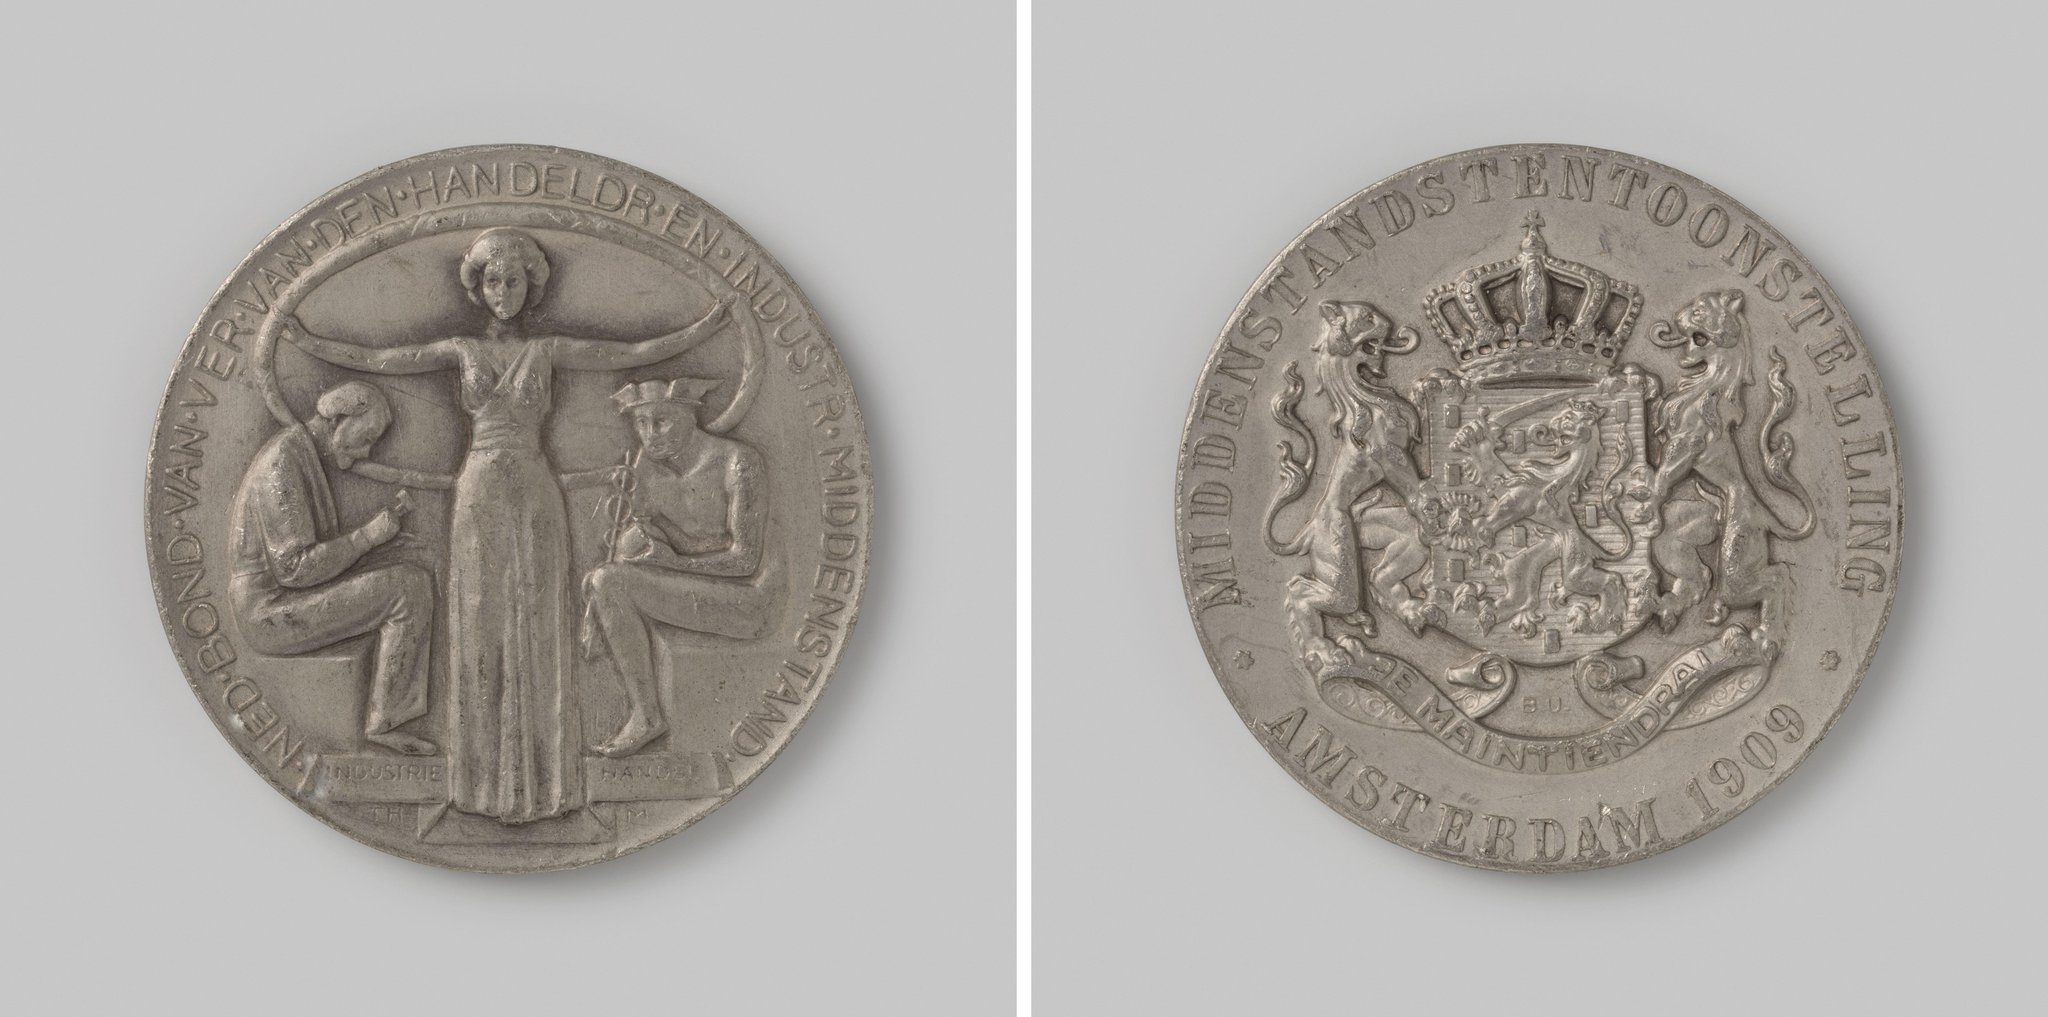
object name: history medal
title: Middenstandstentoonstelling te Amsterdam 1909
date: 1909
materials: tin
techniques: striking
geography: utrecht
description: Tinnen penning, op de voorzijde een vrouw met grote ring boven het hoofd tussen een handwerksman en Mercurius, op tekstlint, met omschrift, op de keerzijde het gekroonde rijkswapen met dragers, met omschrift.